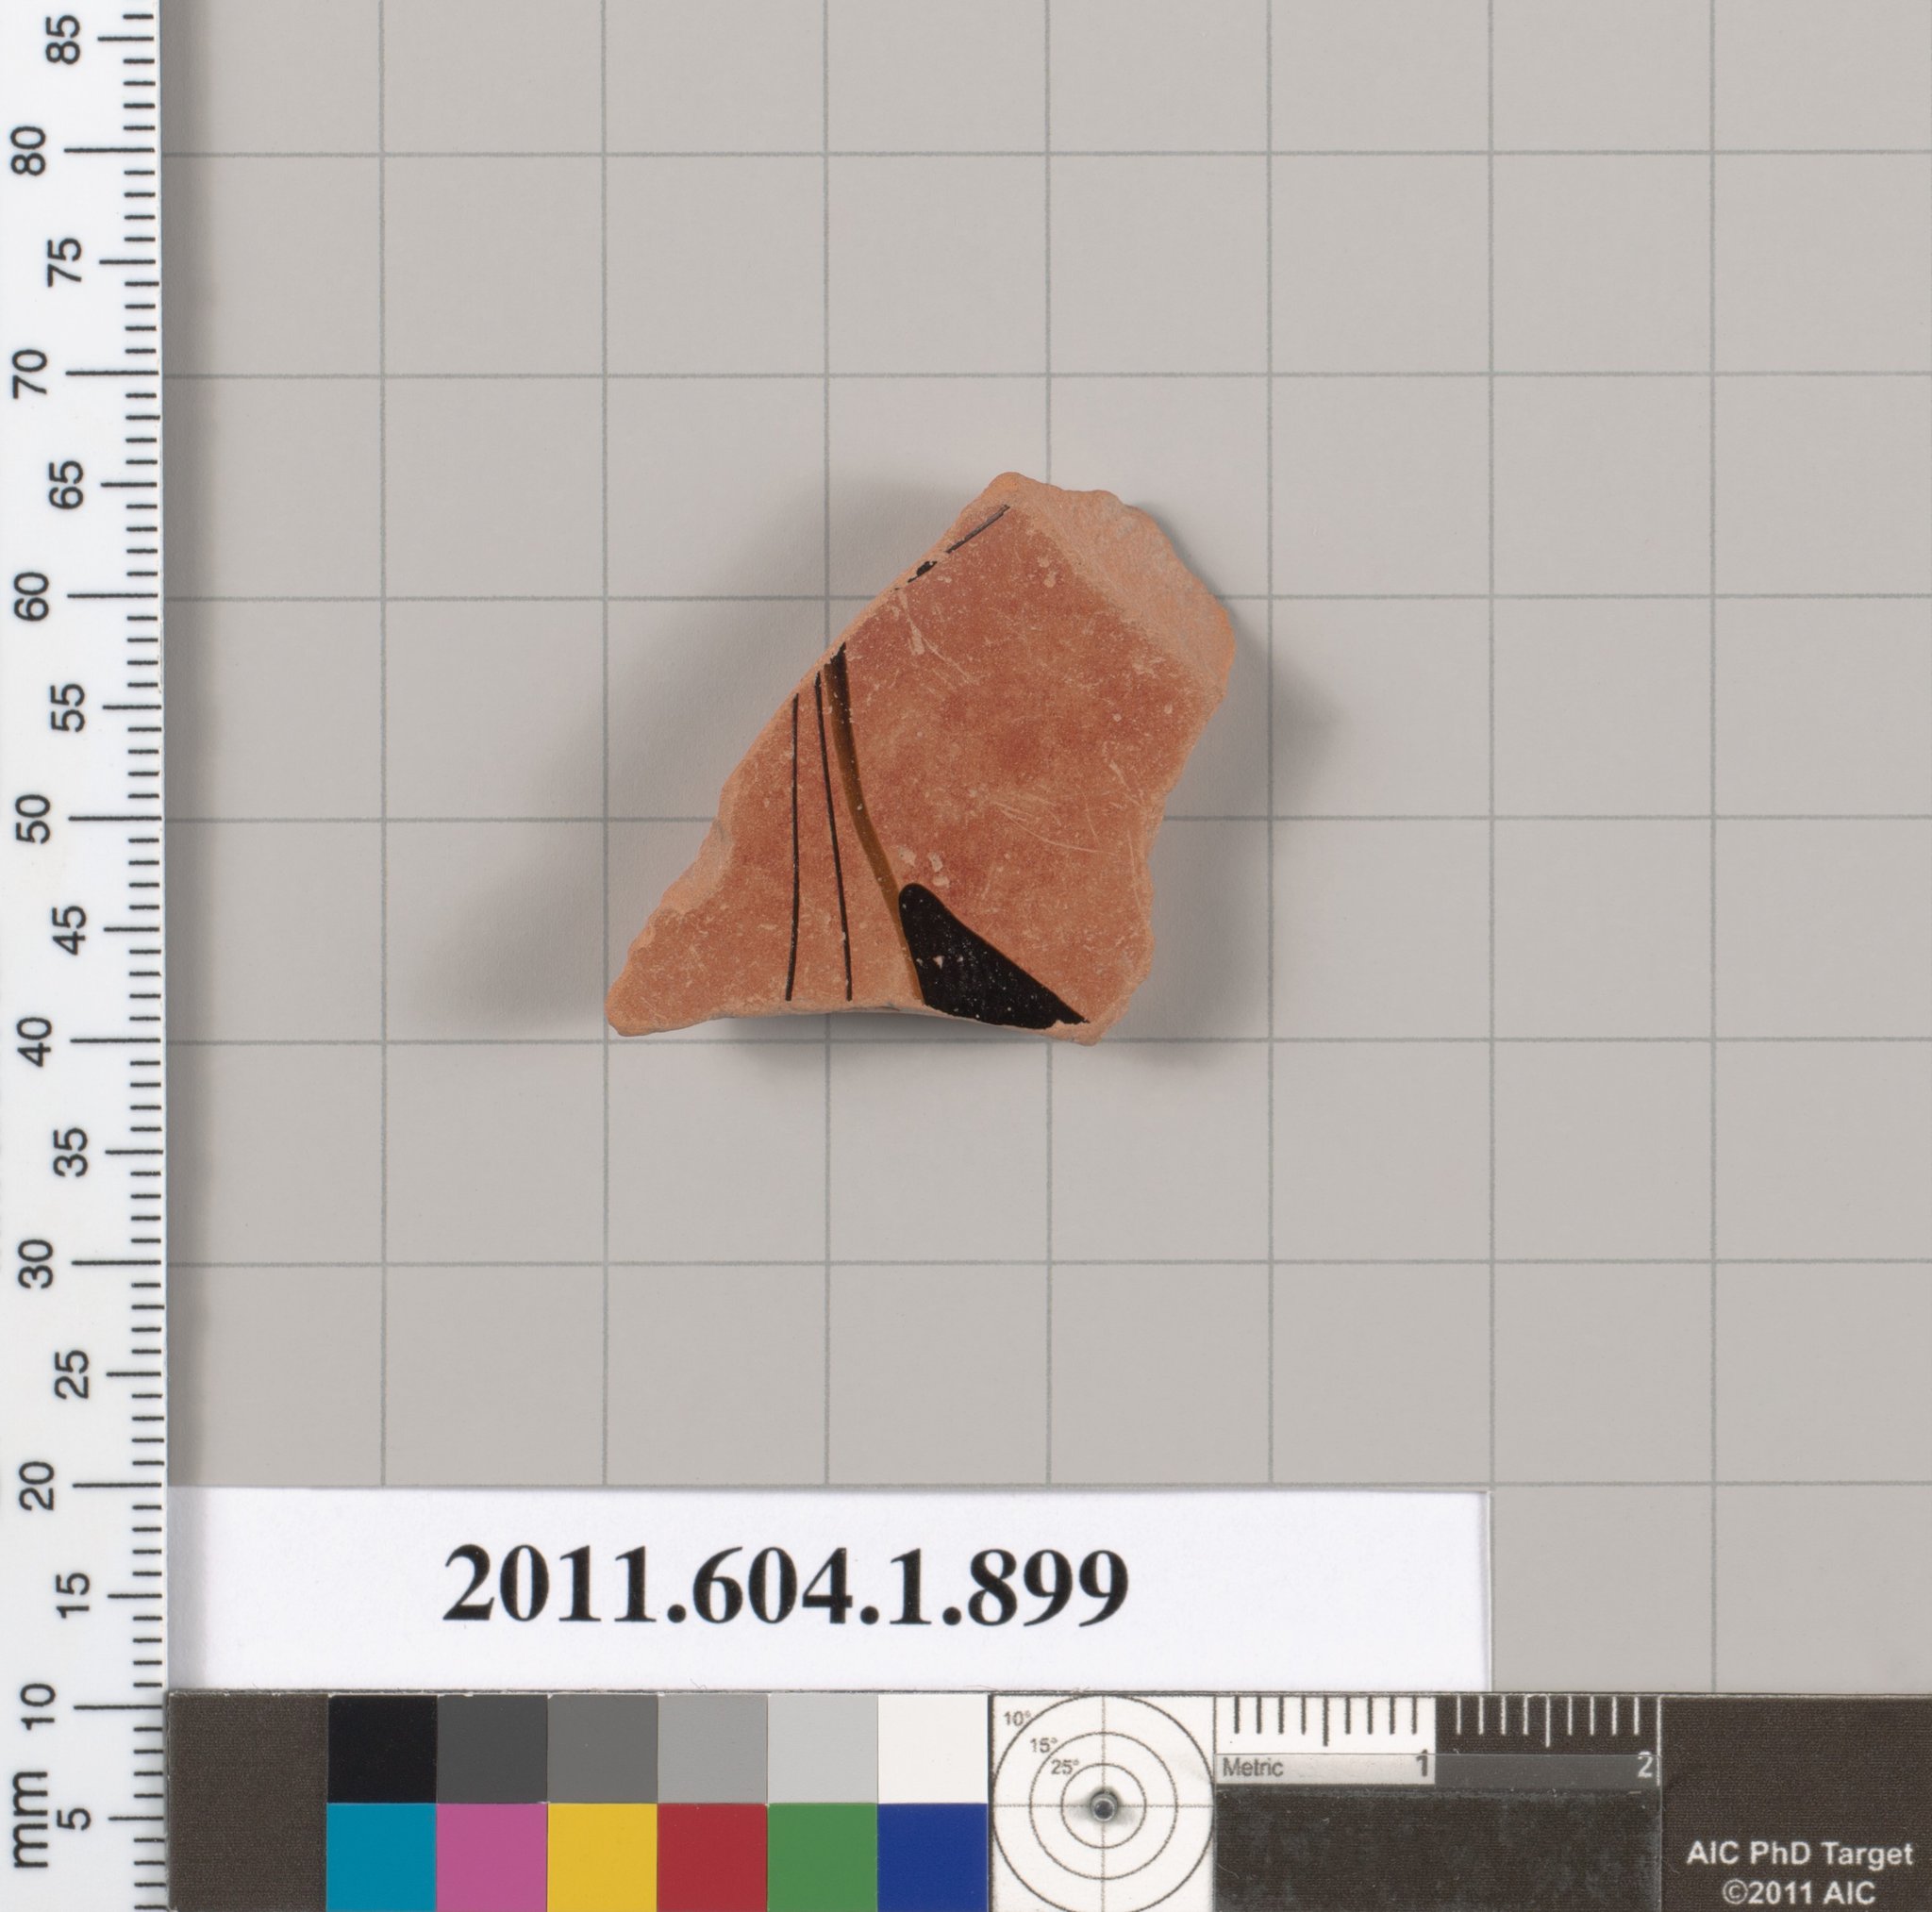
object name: kylix fragment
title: Terracotta fragment of a kylix (drinking cup)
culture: greek, attic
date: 475-451 BCE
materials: terracotta